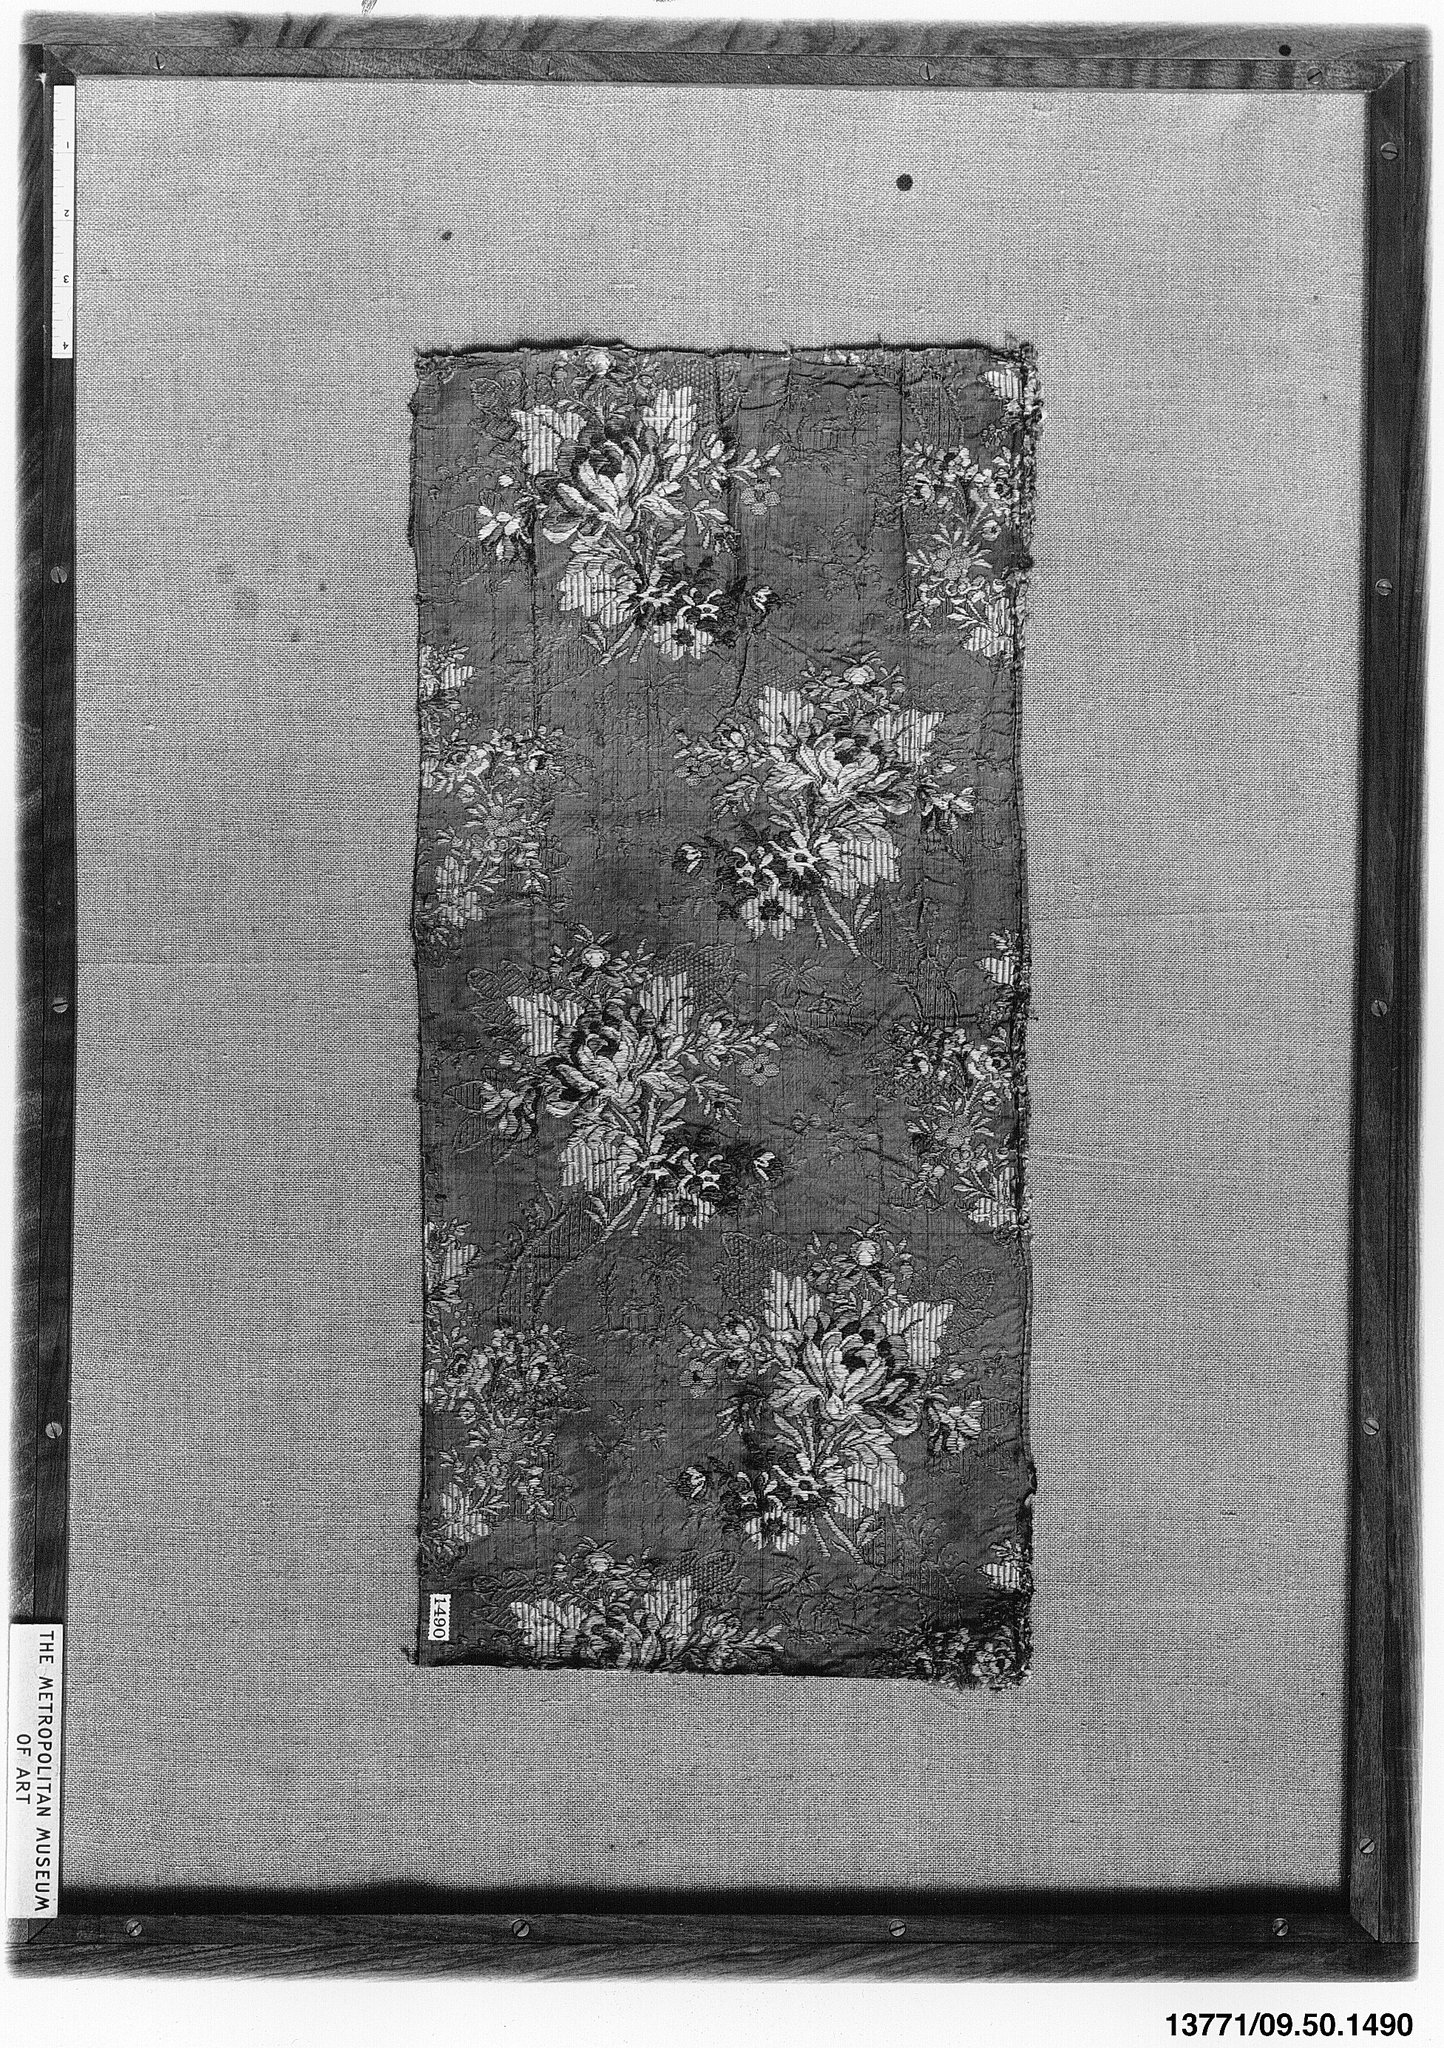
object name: piece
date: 1750-1760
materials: silk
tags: flowers,leaves